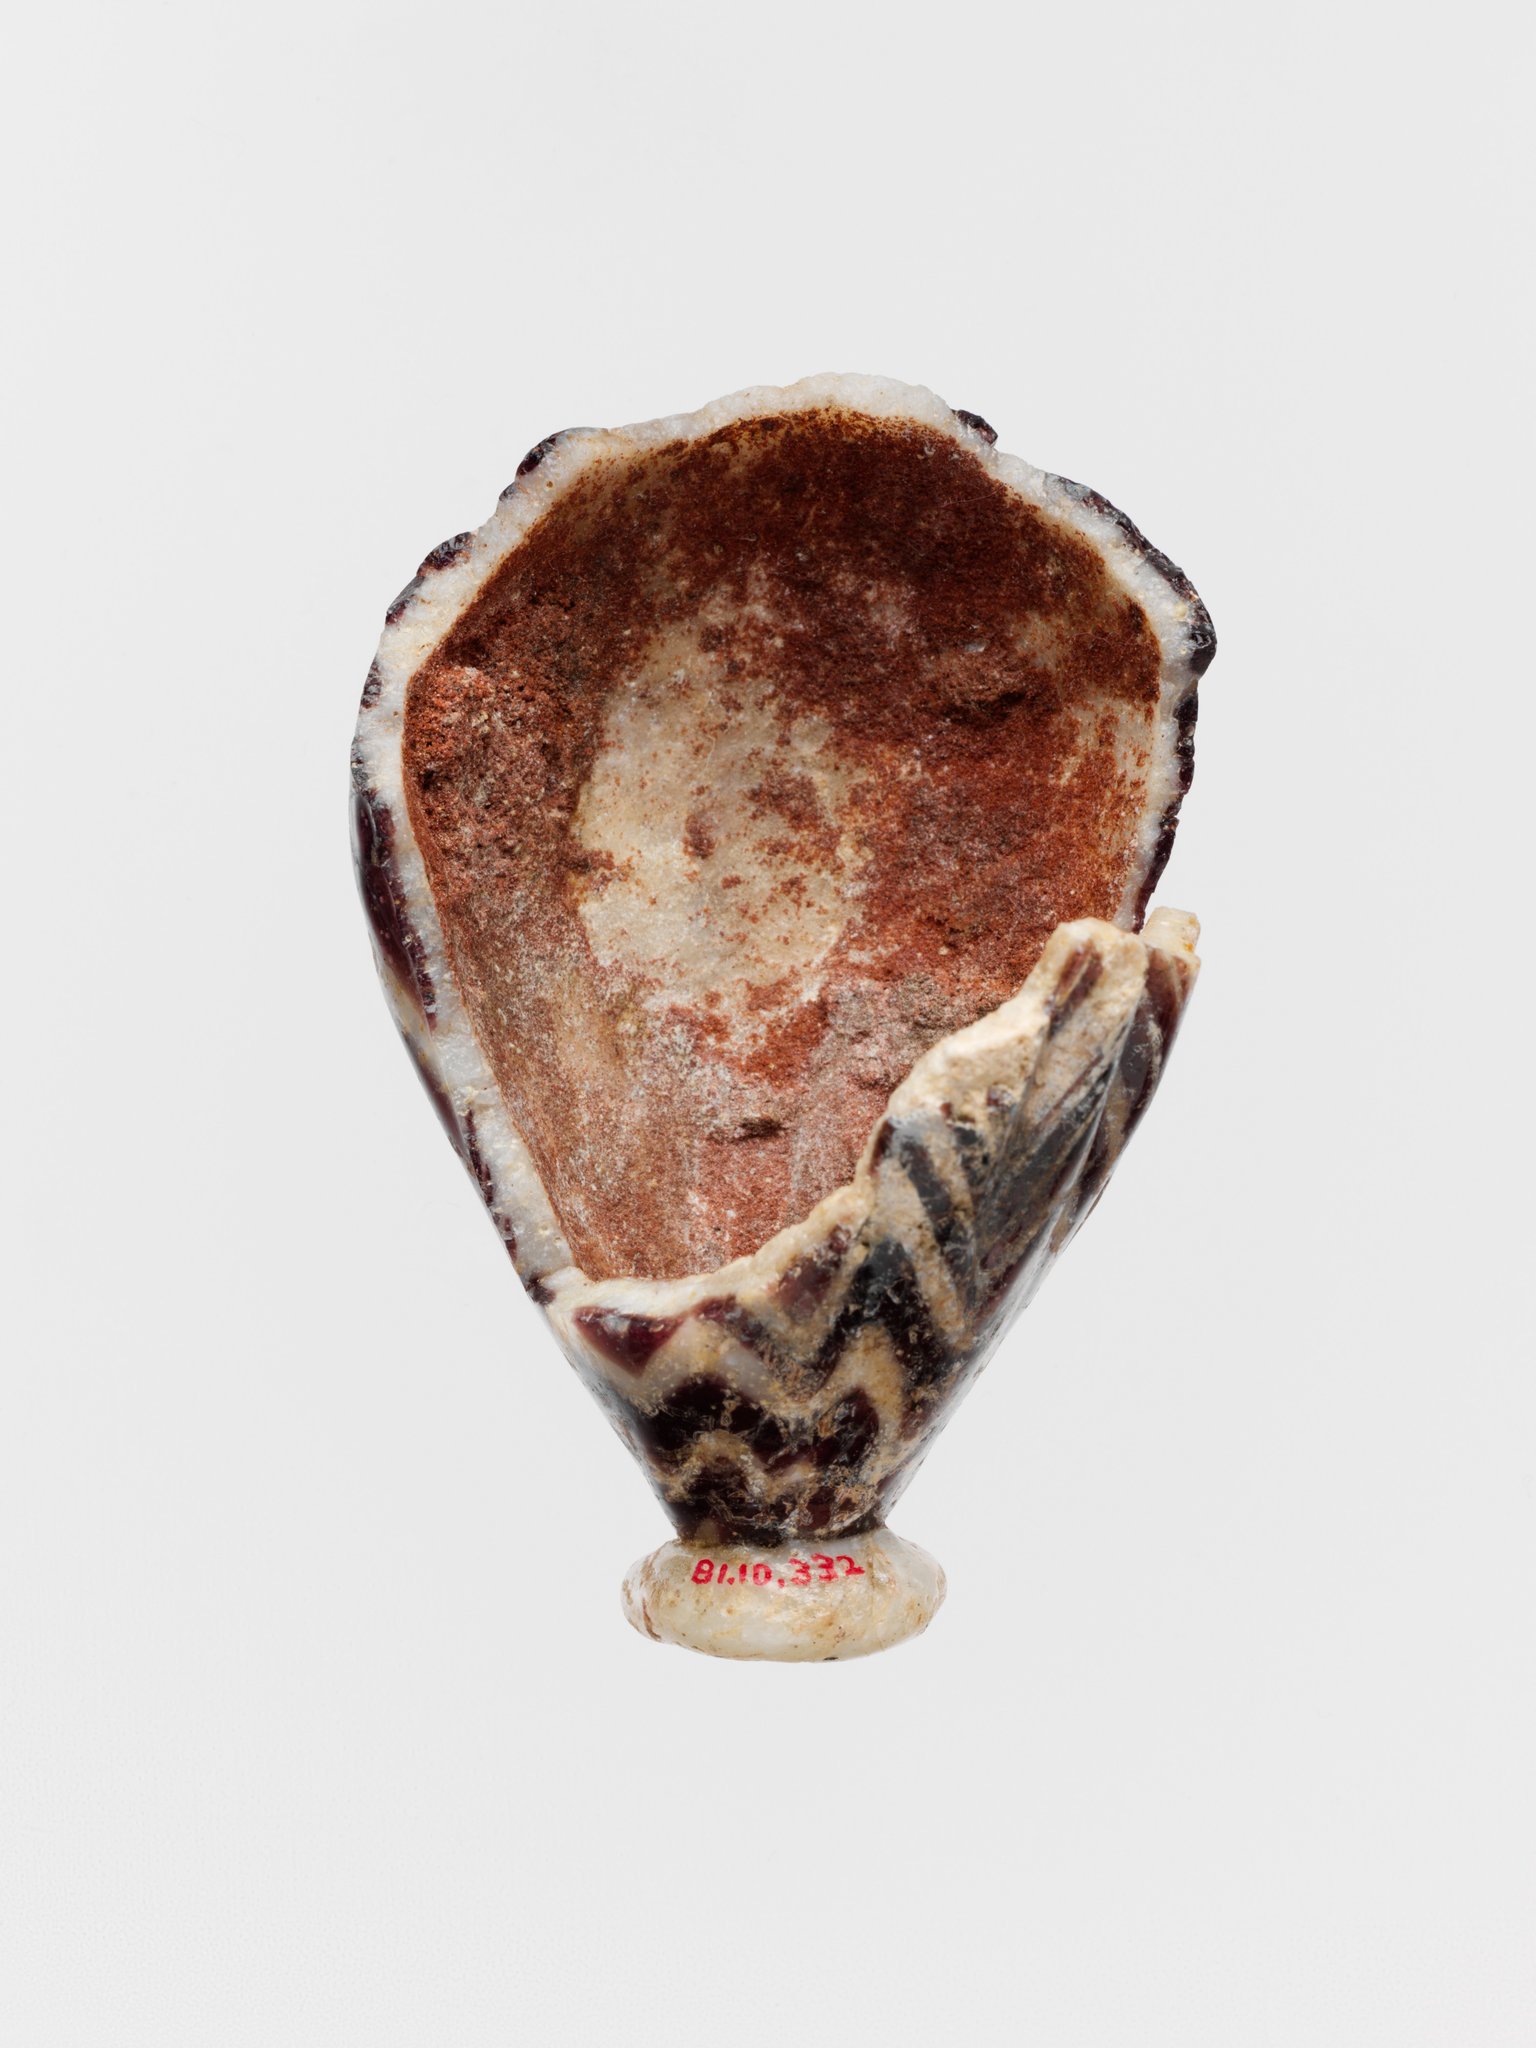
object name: amphoriskos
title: Glass amphoriskos (perfume bottle)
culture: greek, eastern mediterranean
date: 534-401 BCE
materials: glass